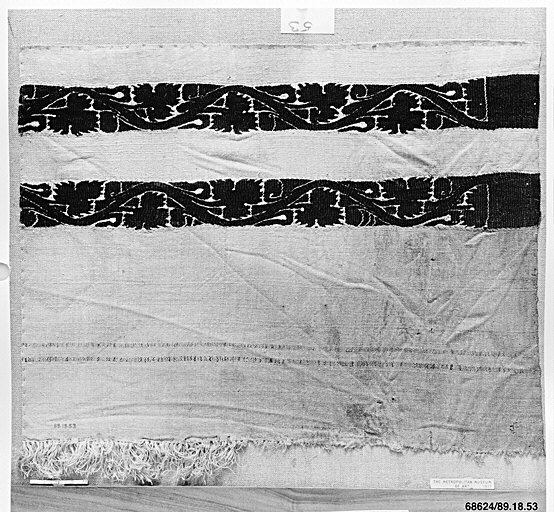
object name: textile fragment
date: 201-400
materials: linen, wool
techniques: weave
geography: egypt